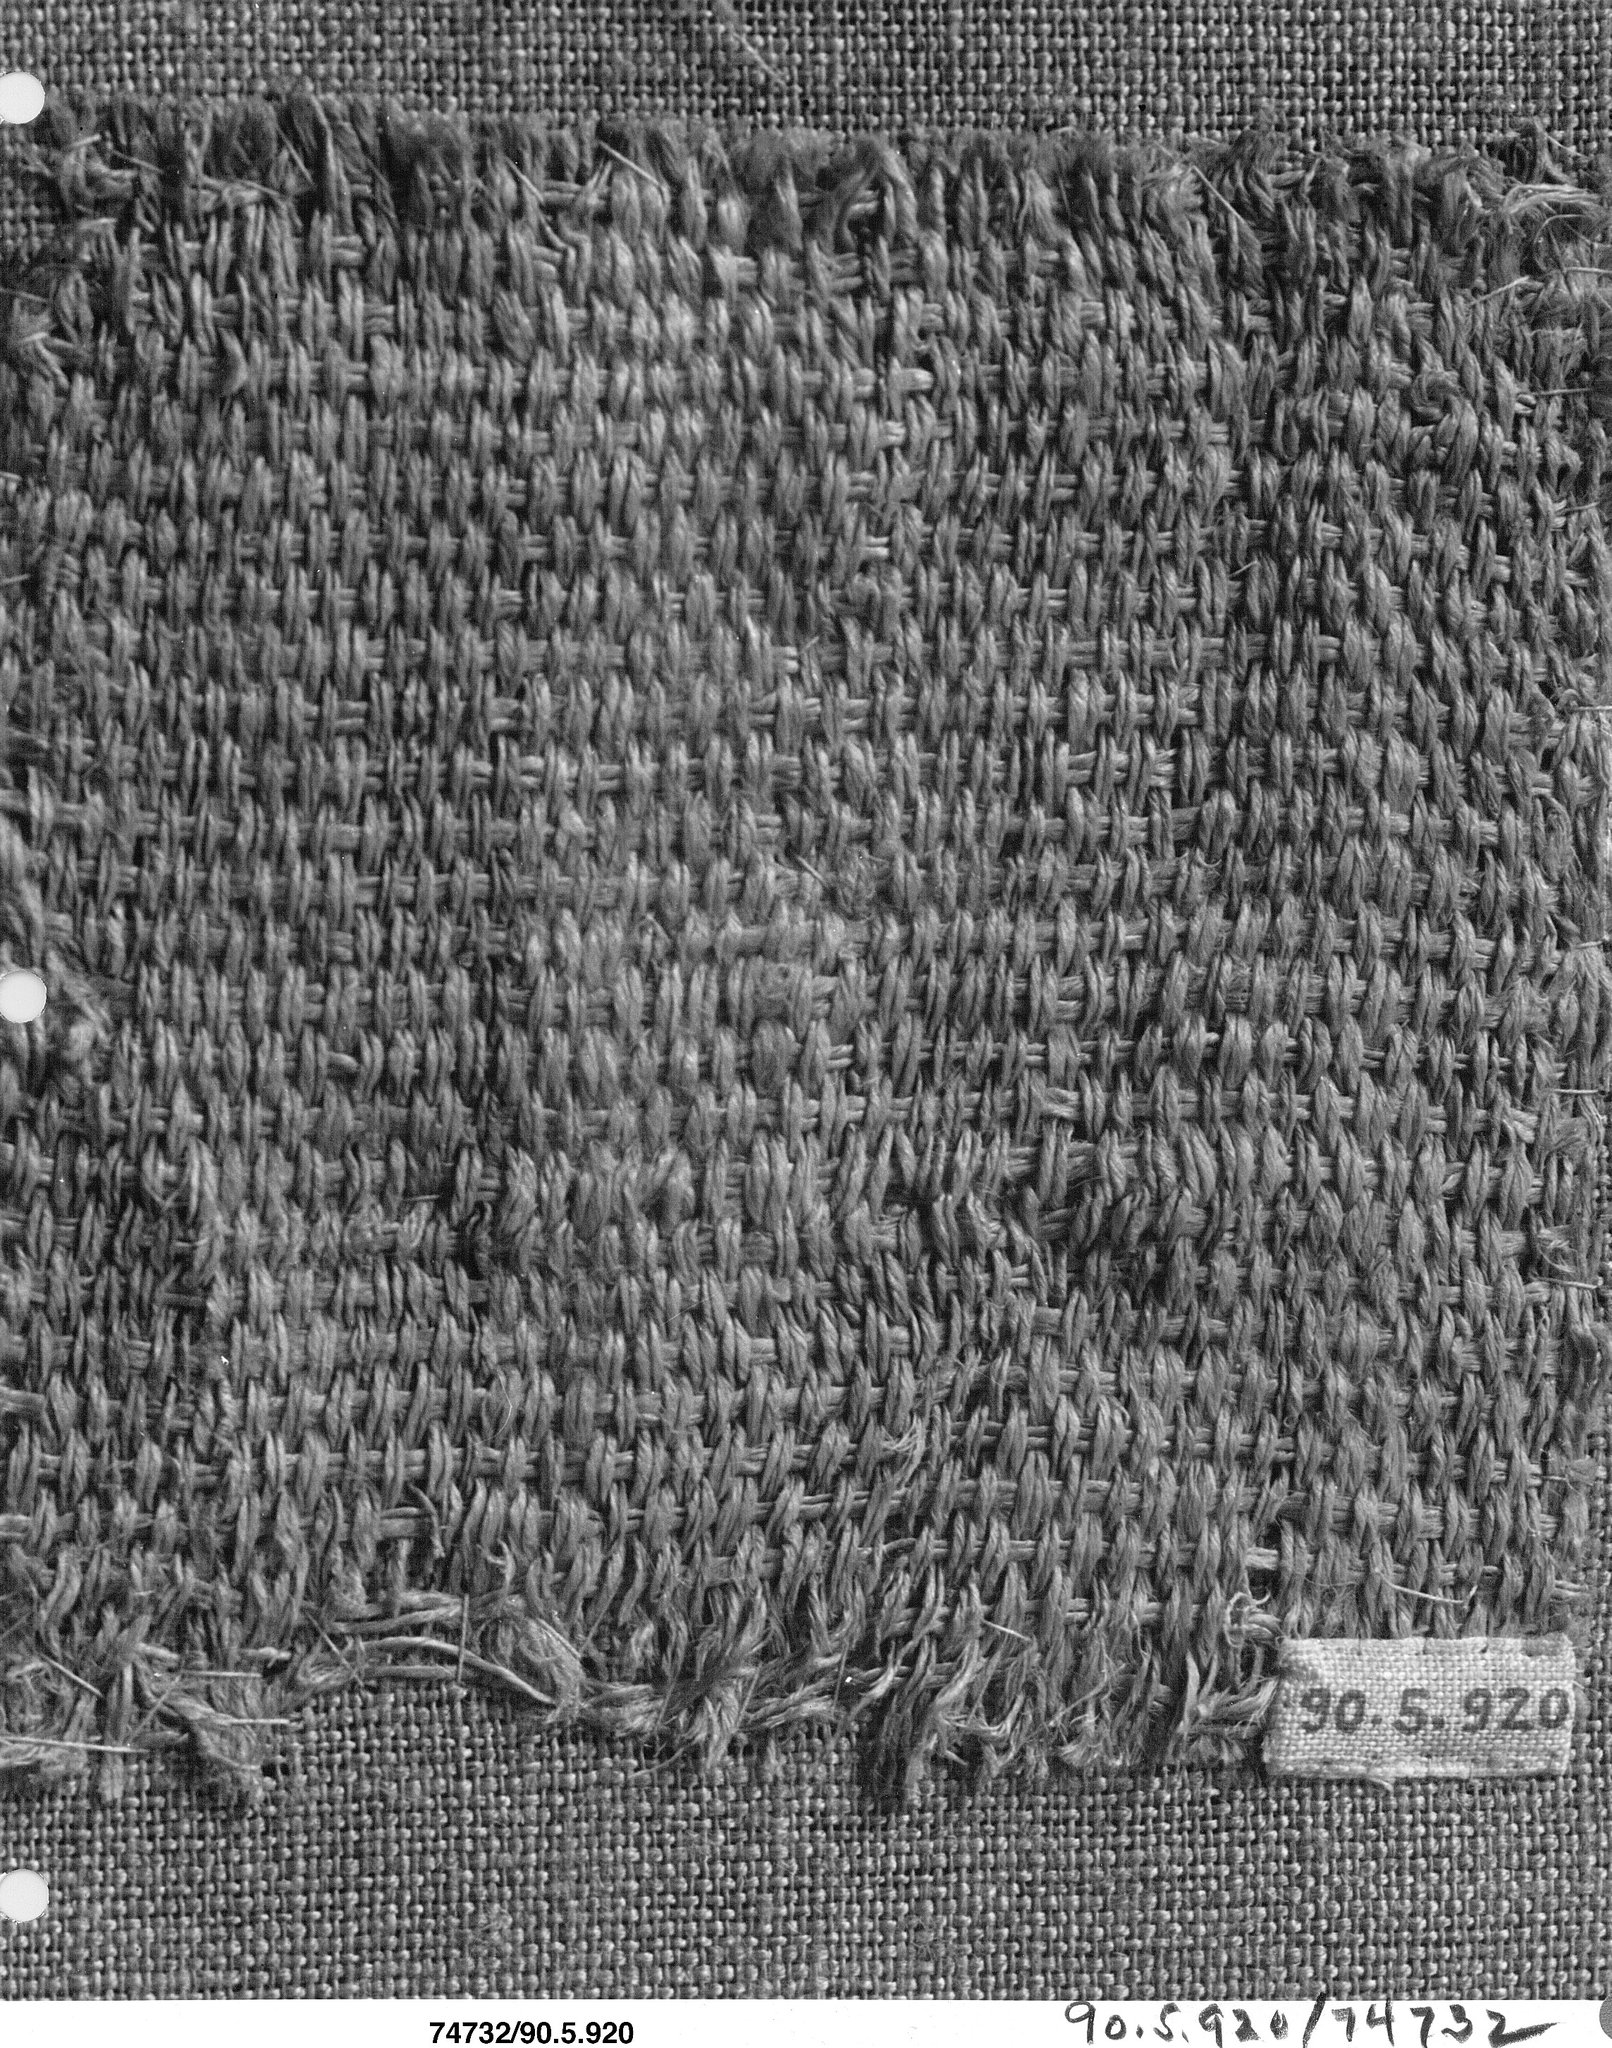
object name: textile fragment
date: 201-500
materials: linen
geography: egypt